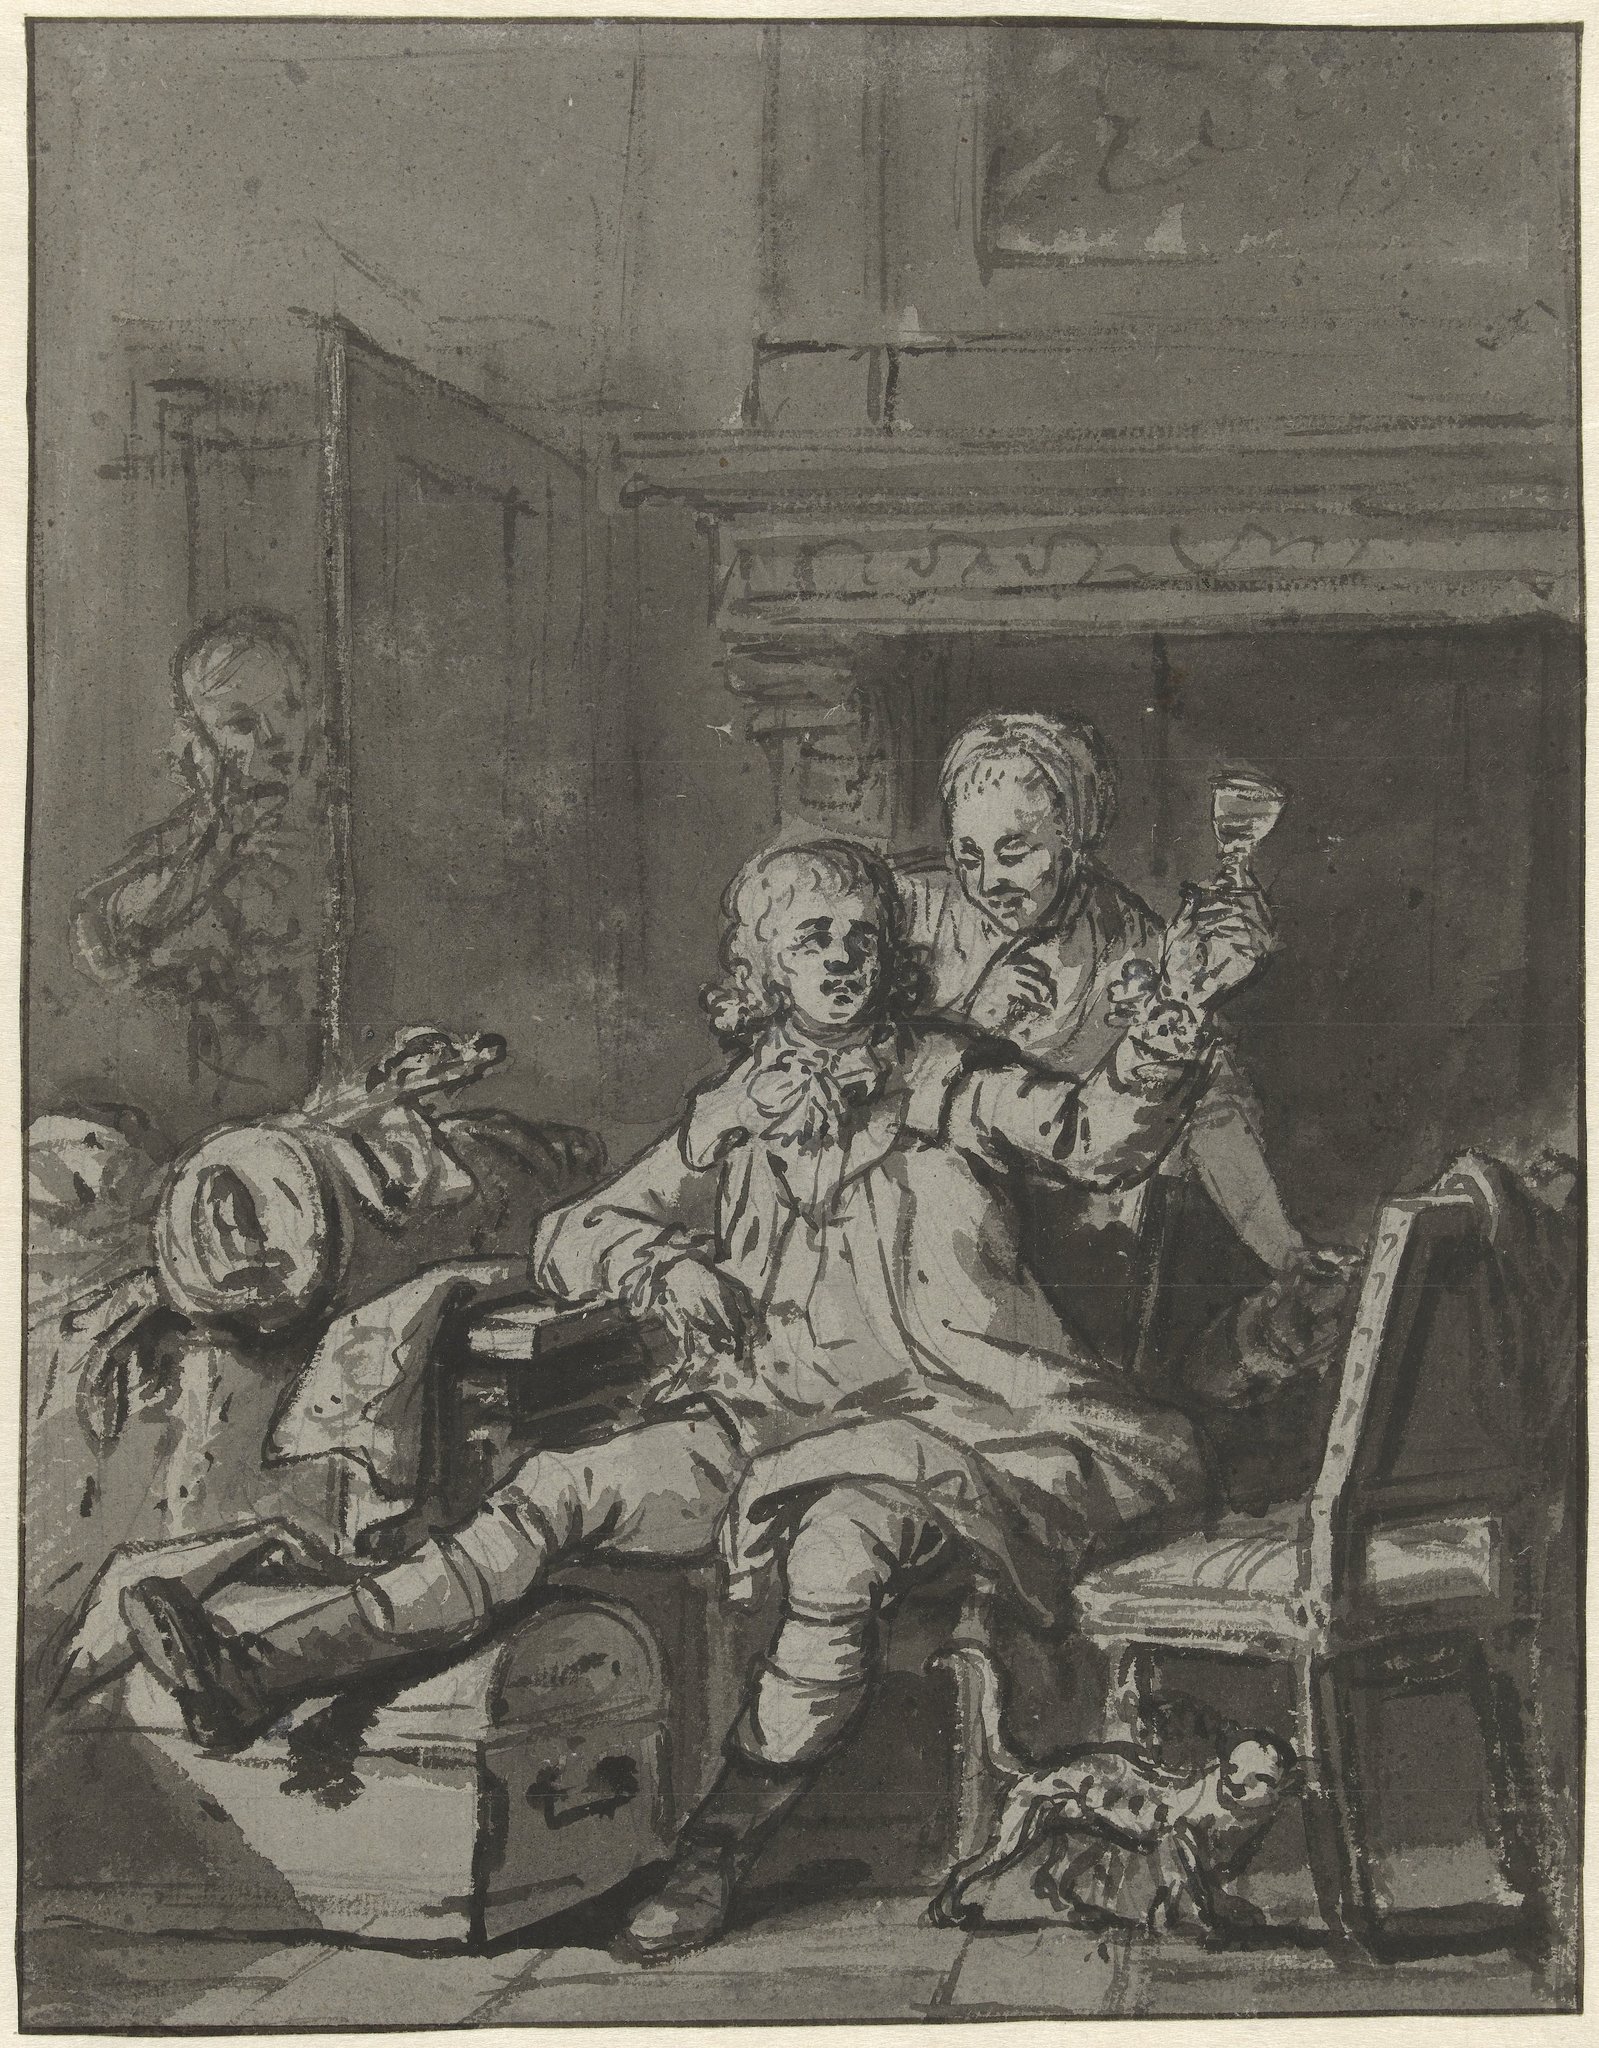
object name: drawing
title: Vrolijk gezelschap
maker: abraham van strij (i)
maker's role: draughtsman, painter, print maker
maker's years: 1753-1826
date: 1763-1826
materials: ink, paper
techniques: brush